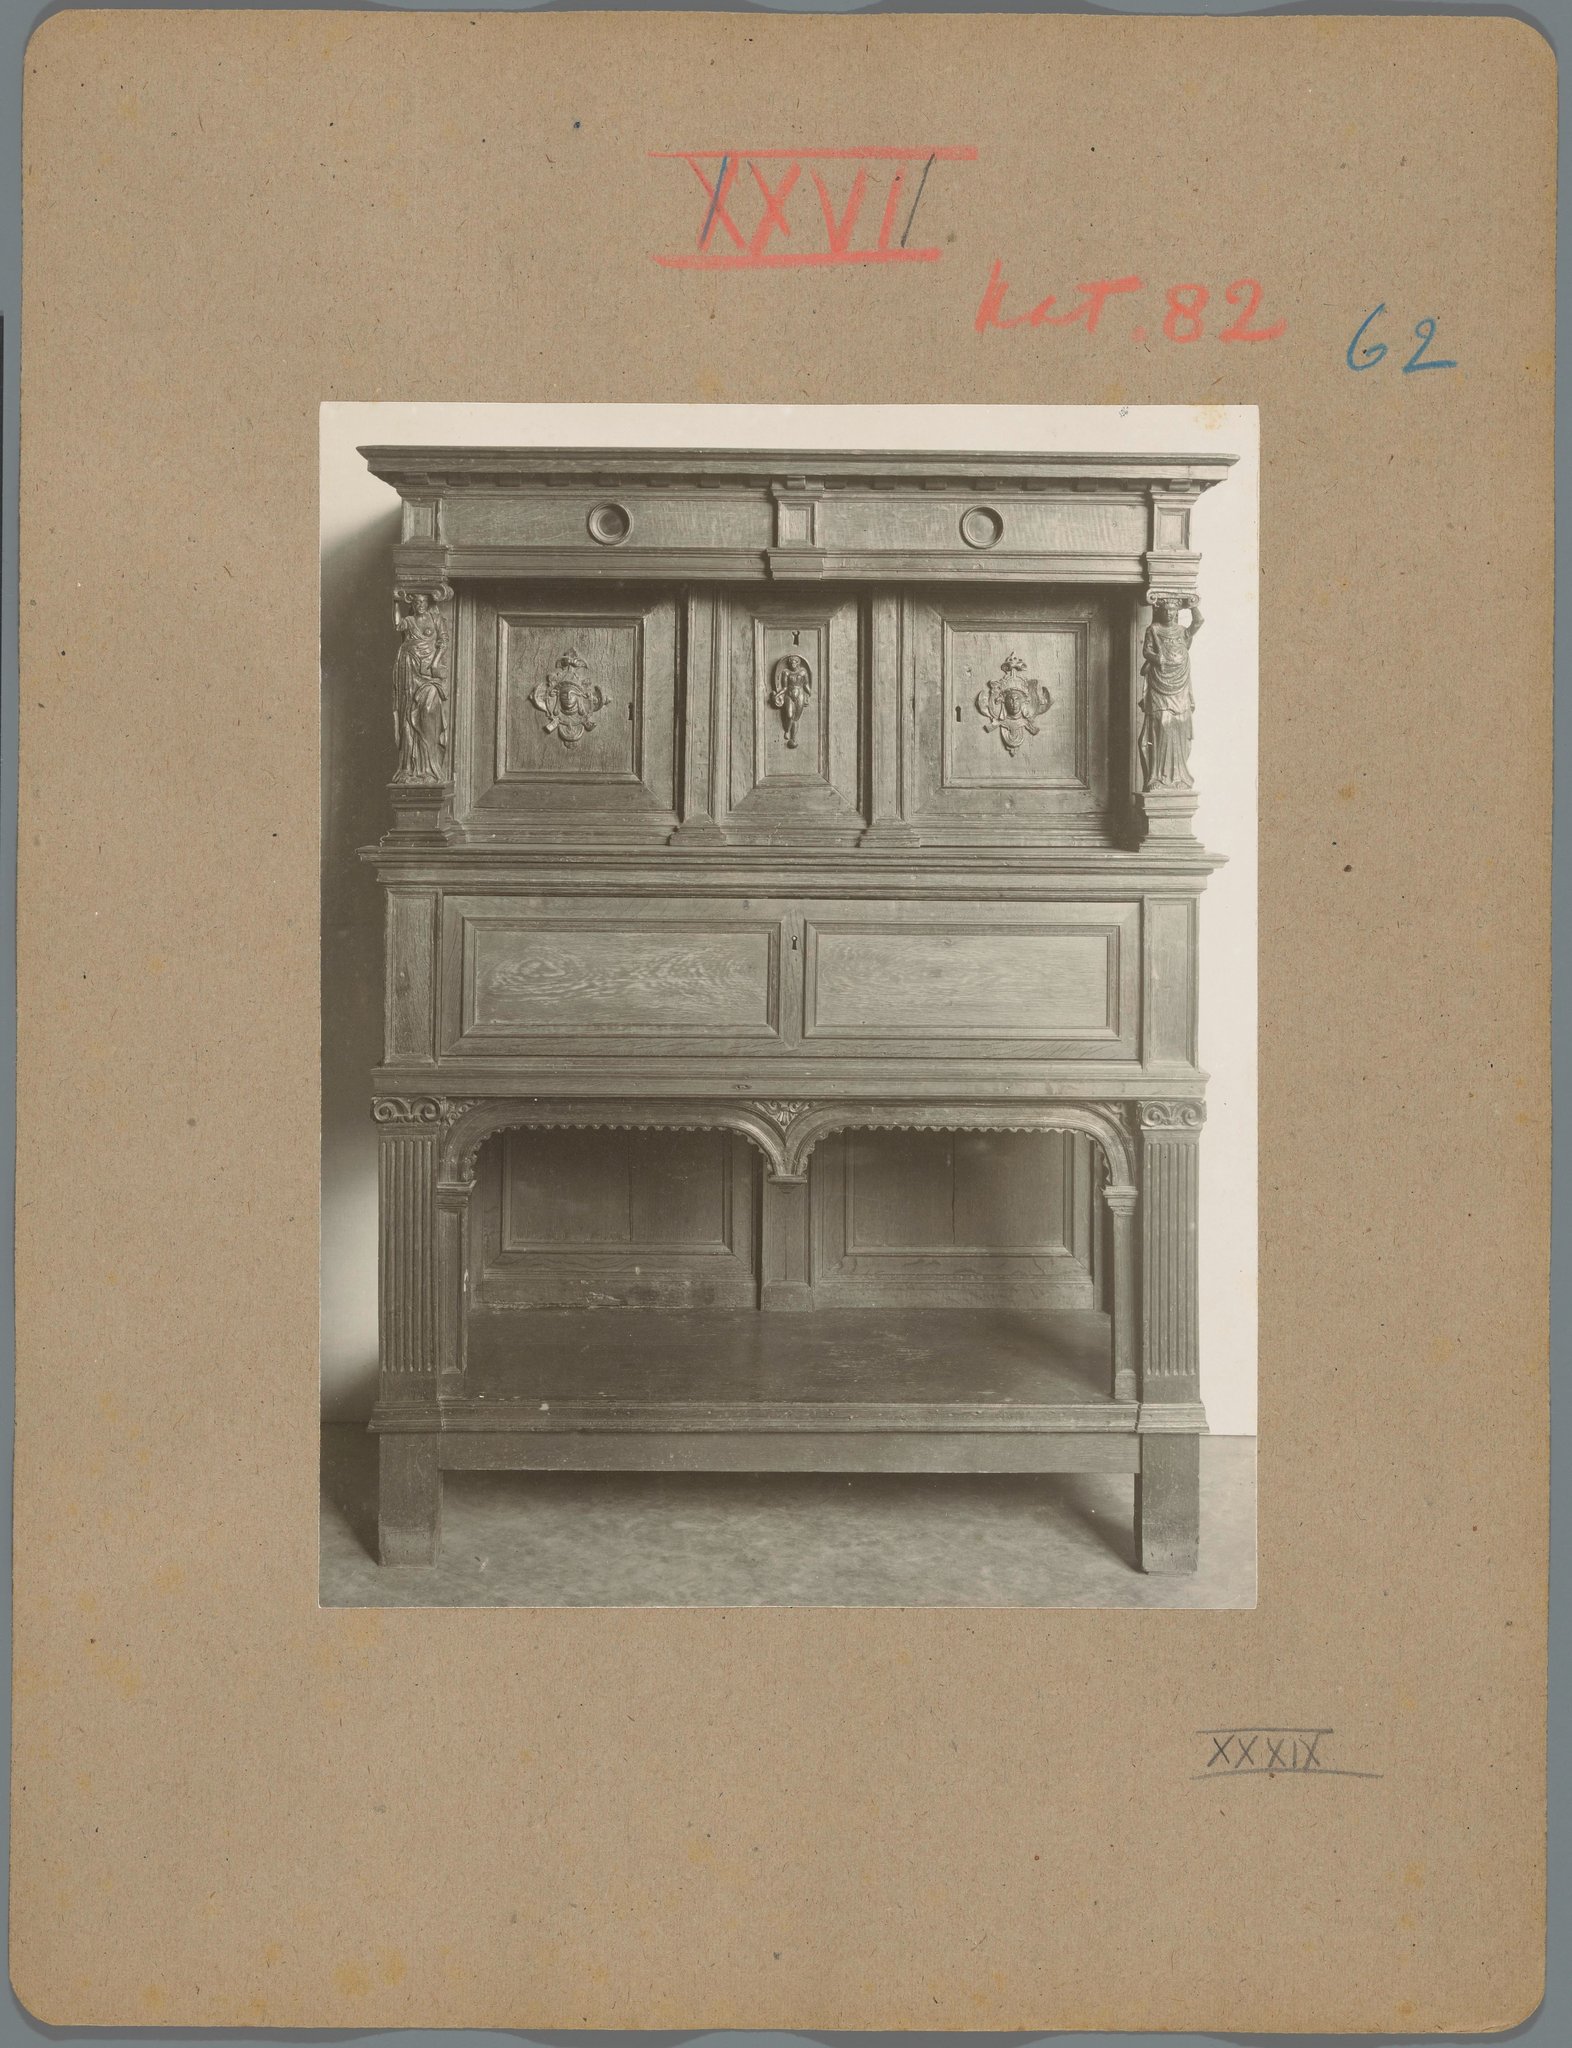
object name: photograph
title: Kast gedecoreerd met hoofden, kariatiden en een afbeelding van Fortuna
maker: Anonymous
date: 1875-1900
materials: cardboard, photographic support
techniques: gelatin silver print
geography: europe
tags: caryatids ~ architecture, fortuna as roman personification, cupboard, europe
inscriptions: number: ‘XXXIX’, number: ‘XXVII’, collector's mark: ‘KUNSTNIJVERHEIDSCHOOL QUELLINUS AMSTERDAM FRANS HALSSTRAAT 14.’, collector's mark: ‘INSTITUUT VOOR KUNST-NIJVERHEIDSONDERWIJS GABRIËL METSUSTRAAT No. 16 AMSTERDAM’, number: ‘62’, number: ‘Kat . 82’